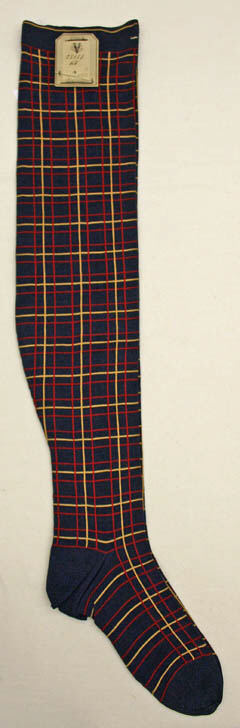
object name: stocking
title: Stockings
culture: french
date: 1873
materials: cotton